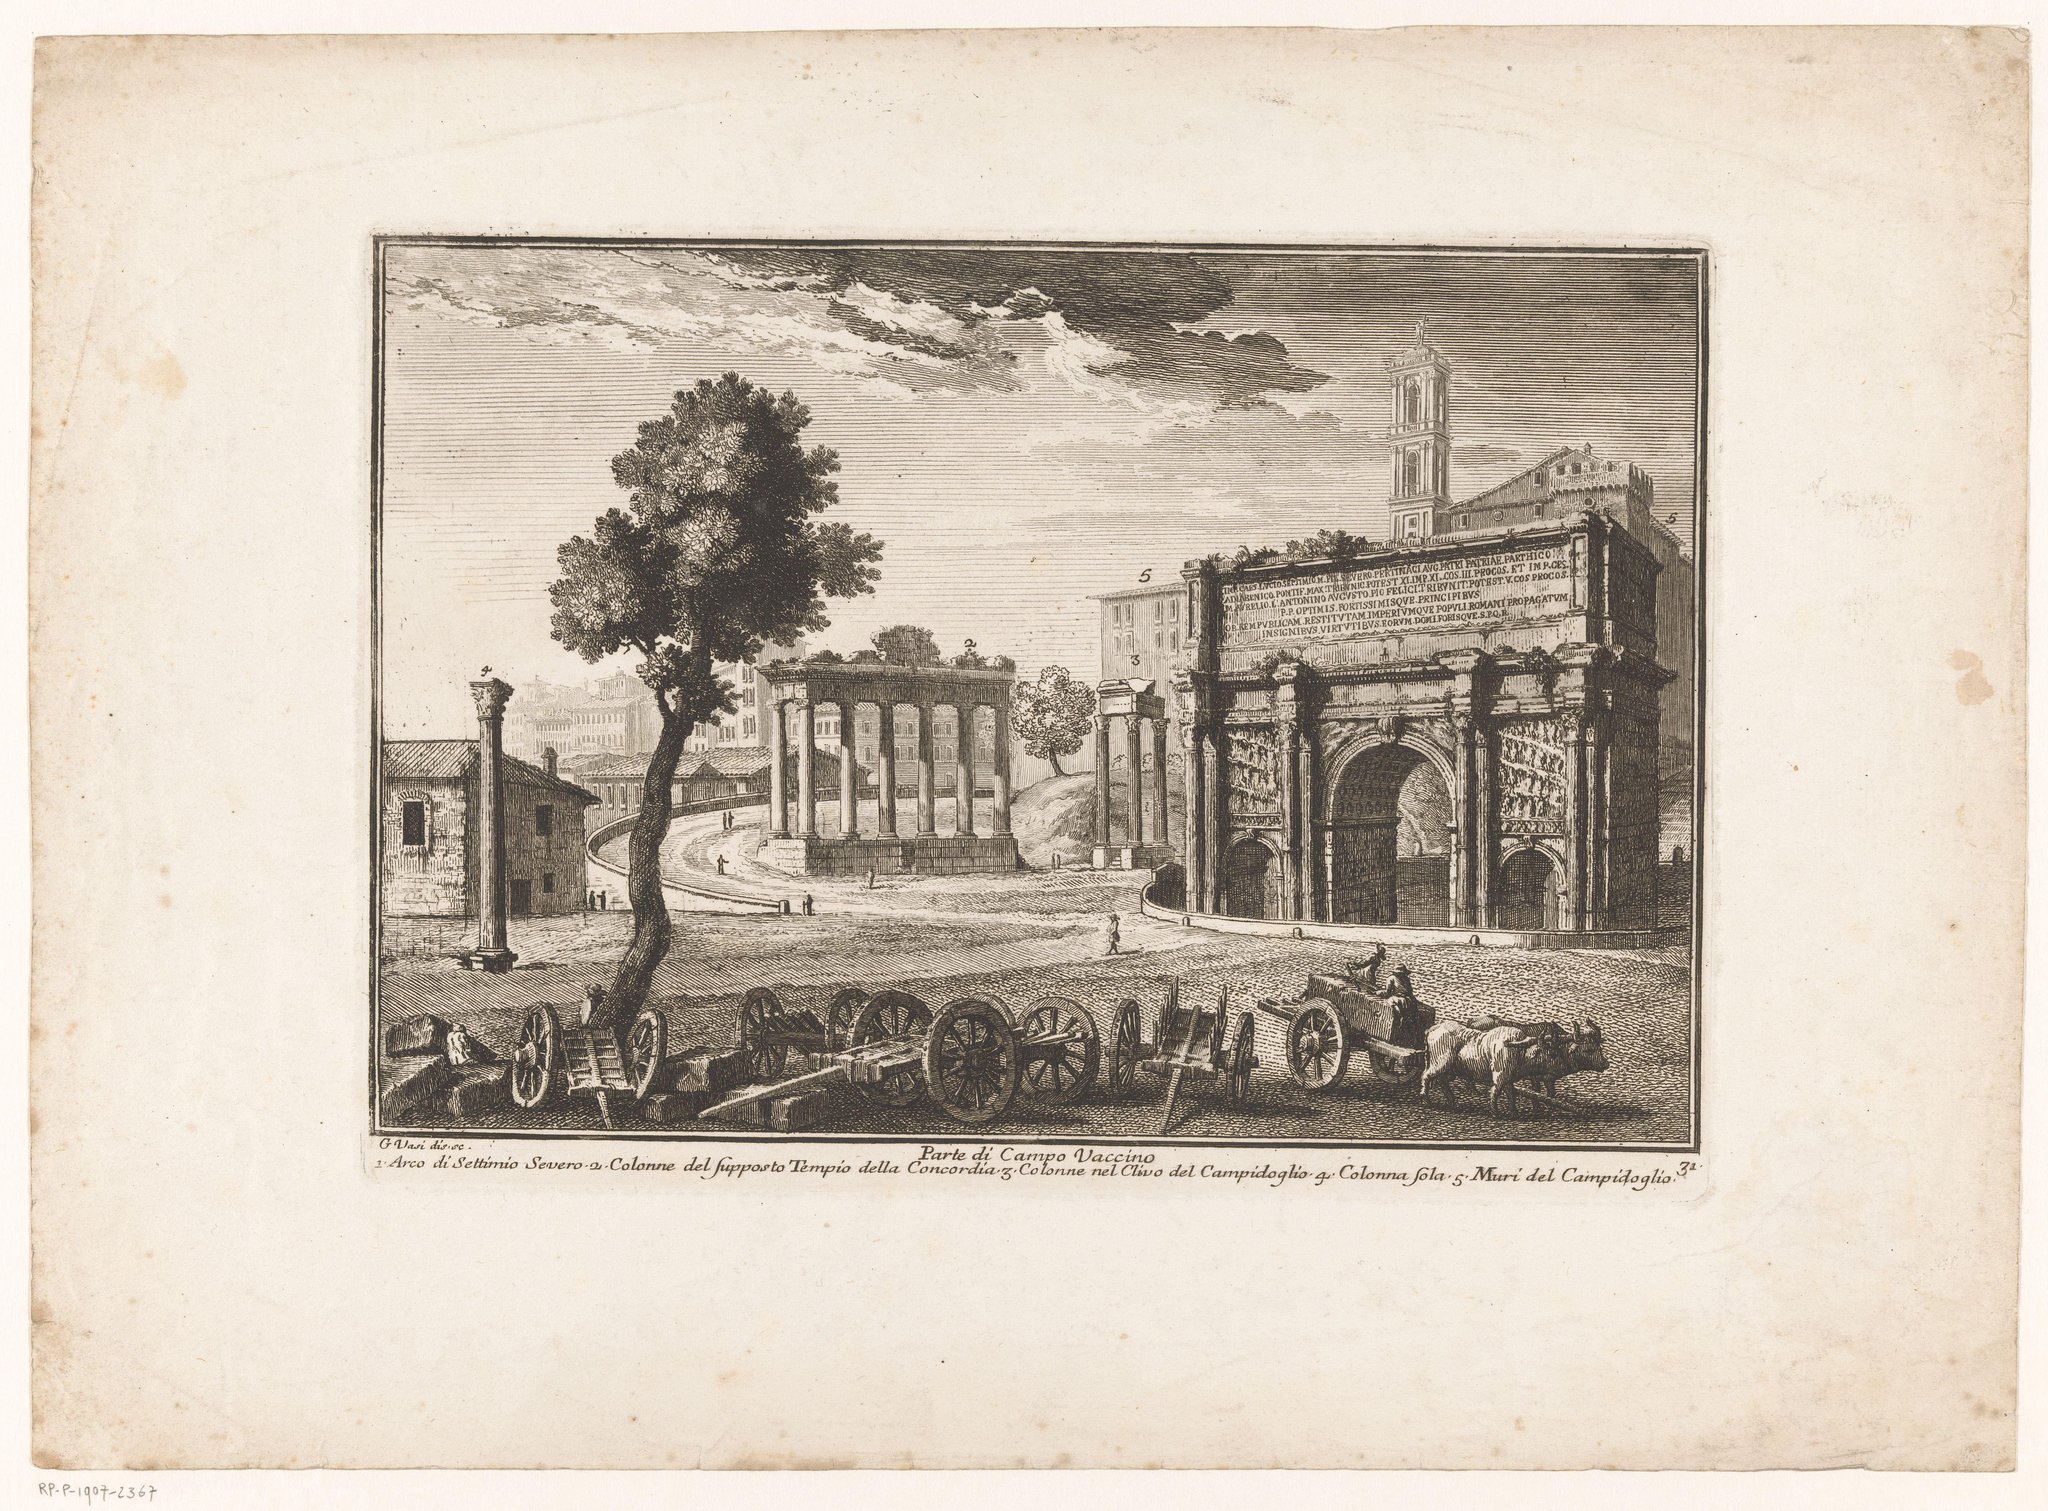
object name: print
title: Delle Magnificenze di Roma Antica e Moderna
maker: giuseppe vasi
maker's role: draughtsman, painter, print maker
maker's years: 1710-1782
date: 1747-1761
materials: paper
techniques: etching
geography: italy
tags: ruin of a building ~ architecture, triumphal arch, temple, shrine ~ roman religion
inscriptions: collector's mark: Lugt 2228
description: Gezicht op het Forum Romanum (destijds bekend als Campo Vaccino) met de Boog van Septimius Severus en de resten van de Tempel van Saturnus (op de prent verward met de resten van de Tempel van Concordia). Genummerd rechtsonder: 31. Titel en verklarende lijst met nummers in ondermarge.